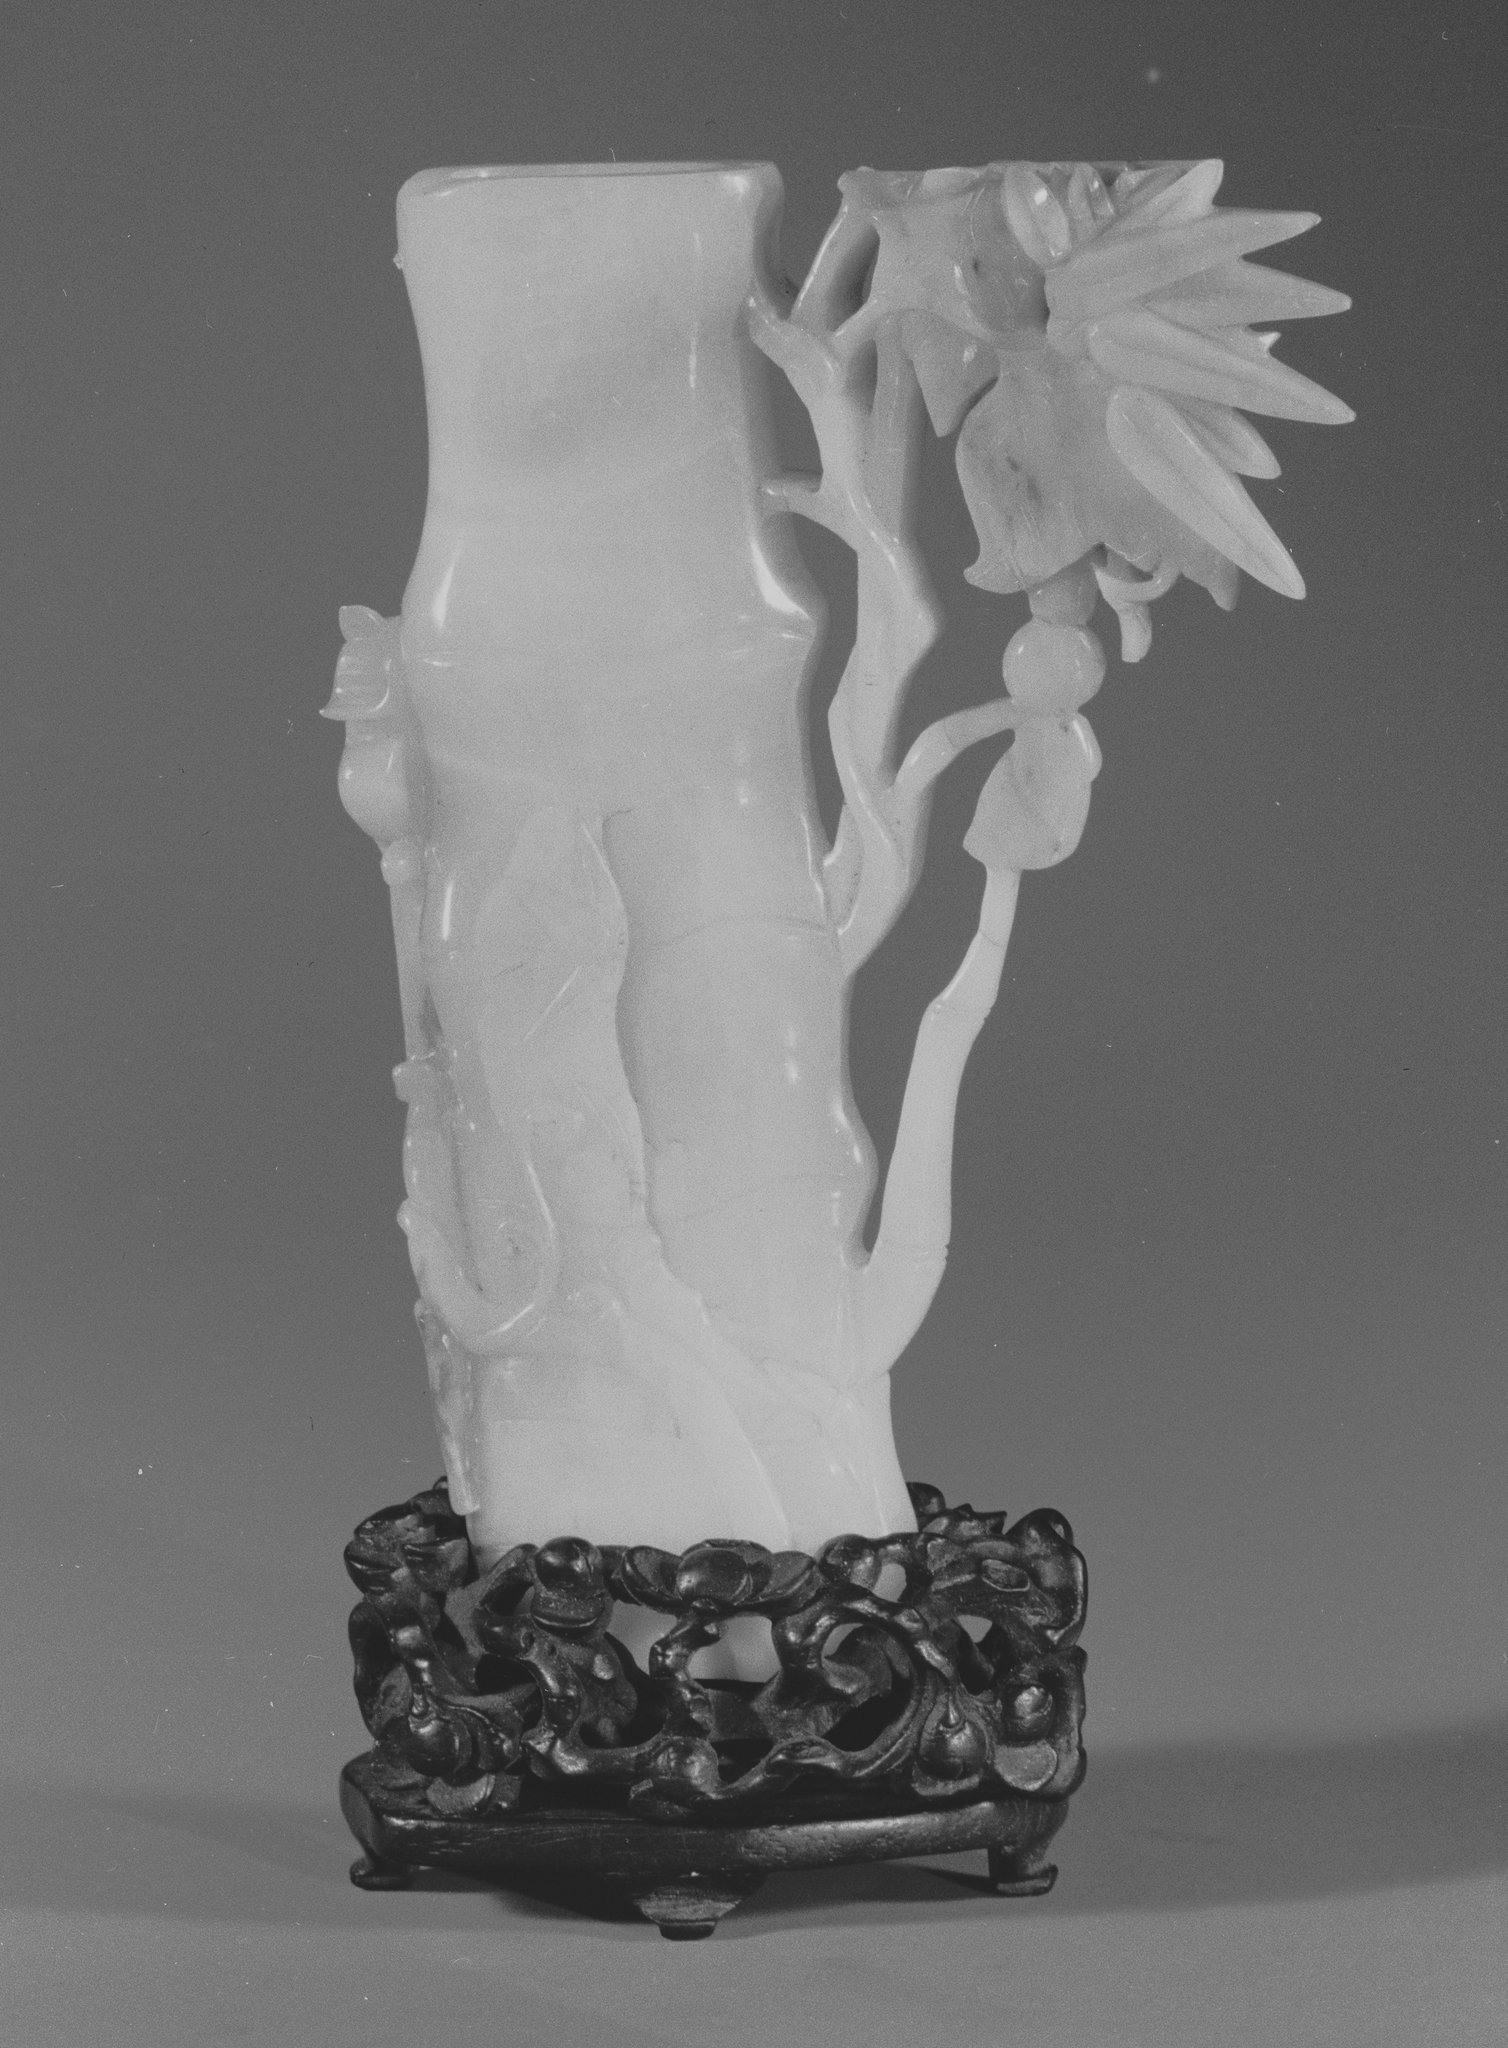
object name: vase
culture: chinese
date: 1901-2000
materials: jade